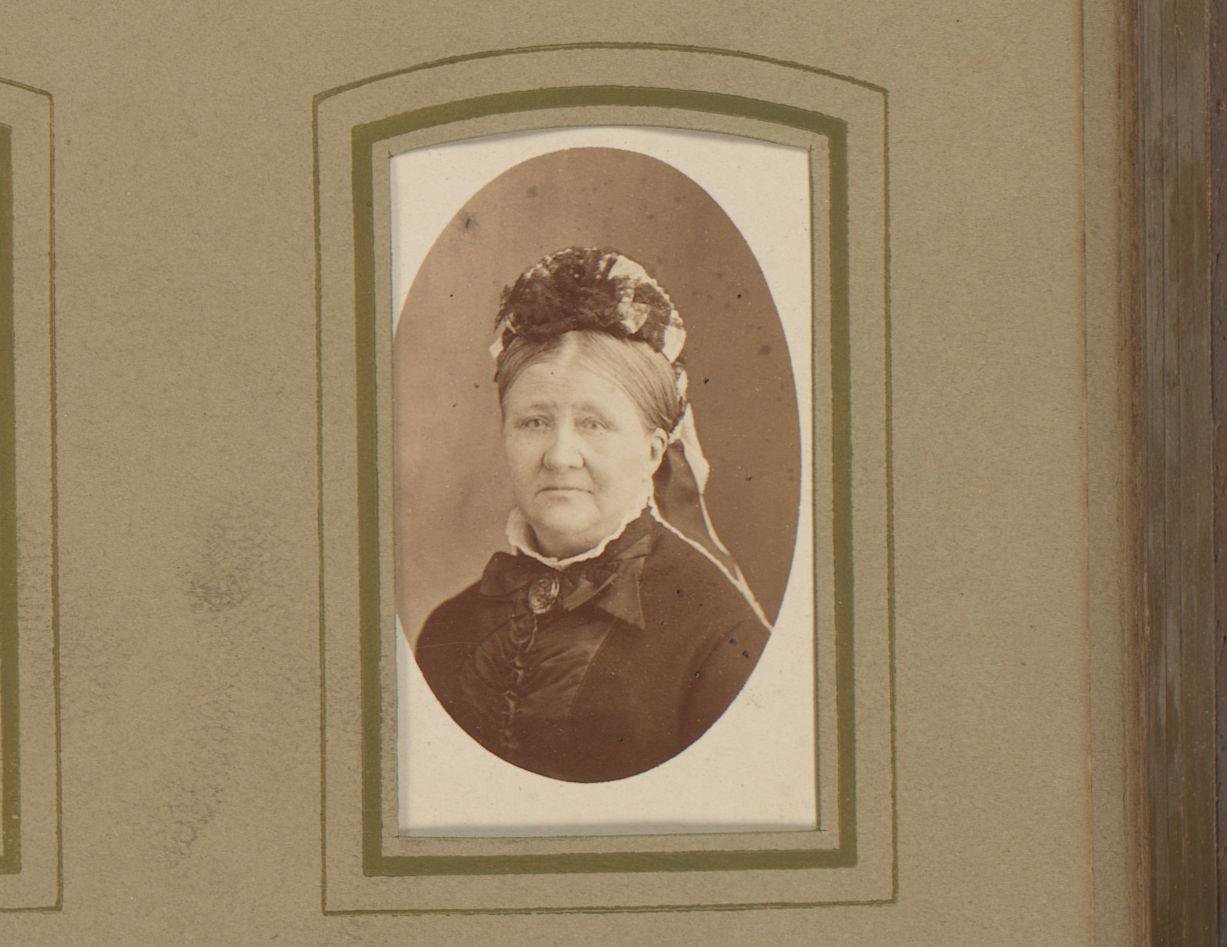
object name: album leaf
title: Portret van een vrouw met hoofddeksel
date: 1867-1884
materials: cardboard, photographic support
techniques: albumen print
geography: amsterdam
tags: head-gear, historical persons - bb - woman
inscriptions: number: ‘6’, inscription: ‘Photographisch Artistisch Atelier/ van/ Wegner & Mottu/ Amsterdam/ Rokin over de Bank/ 138./ Utrecht/ Hamburgerstraat/ F. 237./ Het cliché wordt voor verdere/ bestellingen bewaard.’